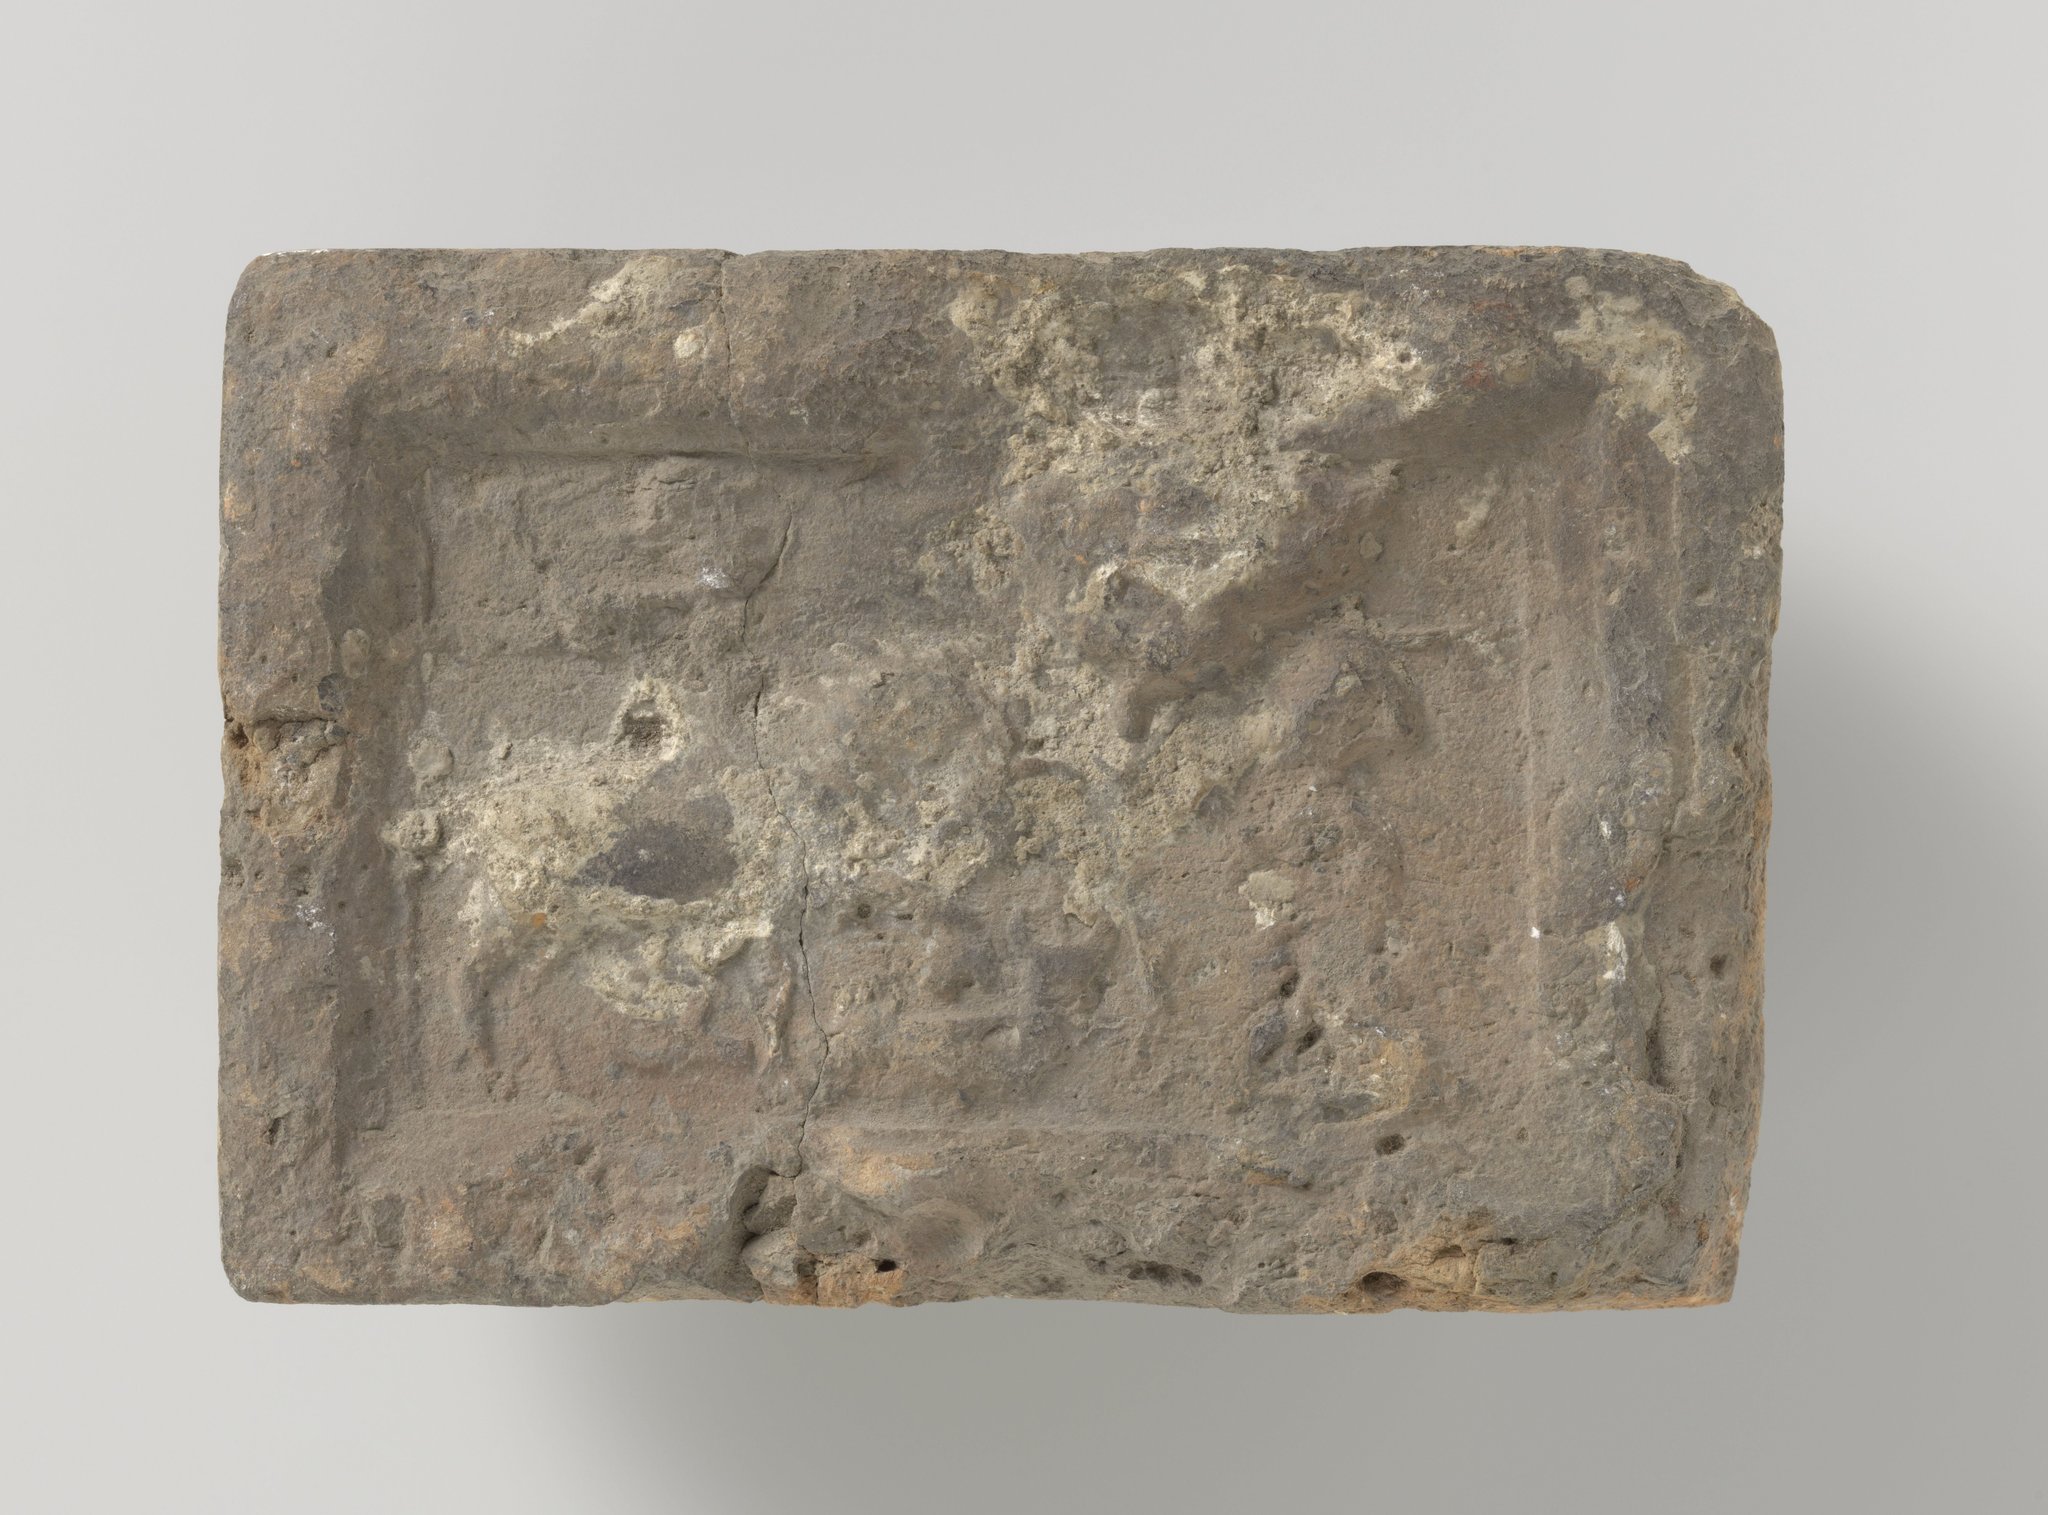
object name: hearthstone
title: Haardsteen met voorstelling van Sint Joris te paard, die de draak doodt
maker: Anonymous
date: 1525-1550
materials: earthenware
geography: southern netherlands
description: Haardsteen met voorstelling van Sint Joris te paard, die de draak doodt, met rechts de prinses.